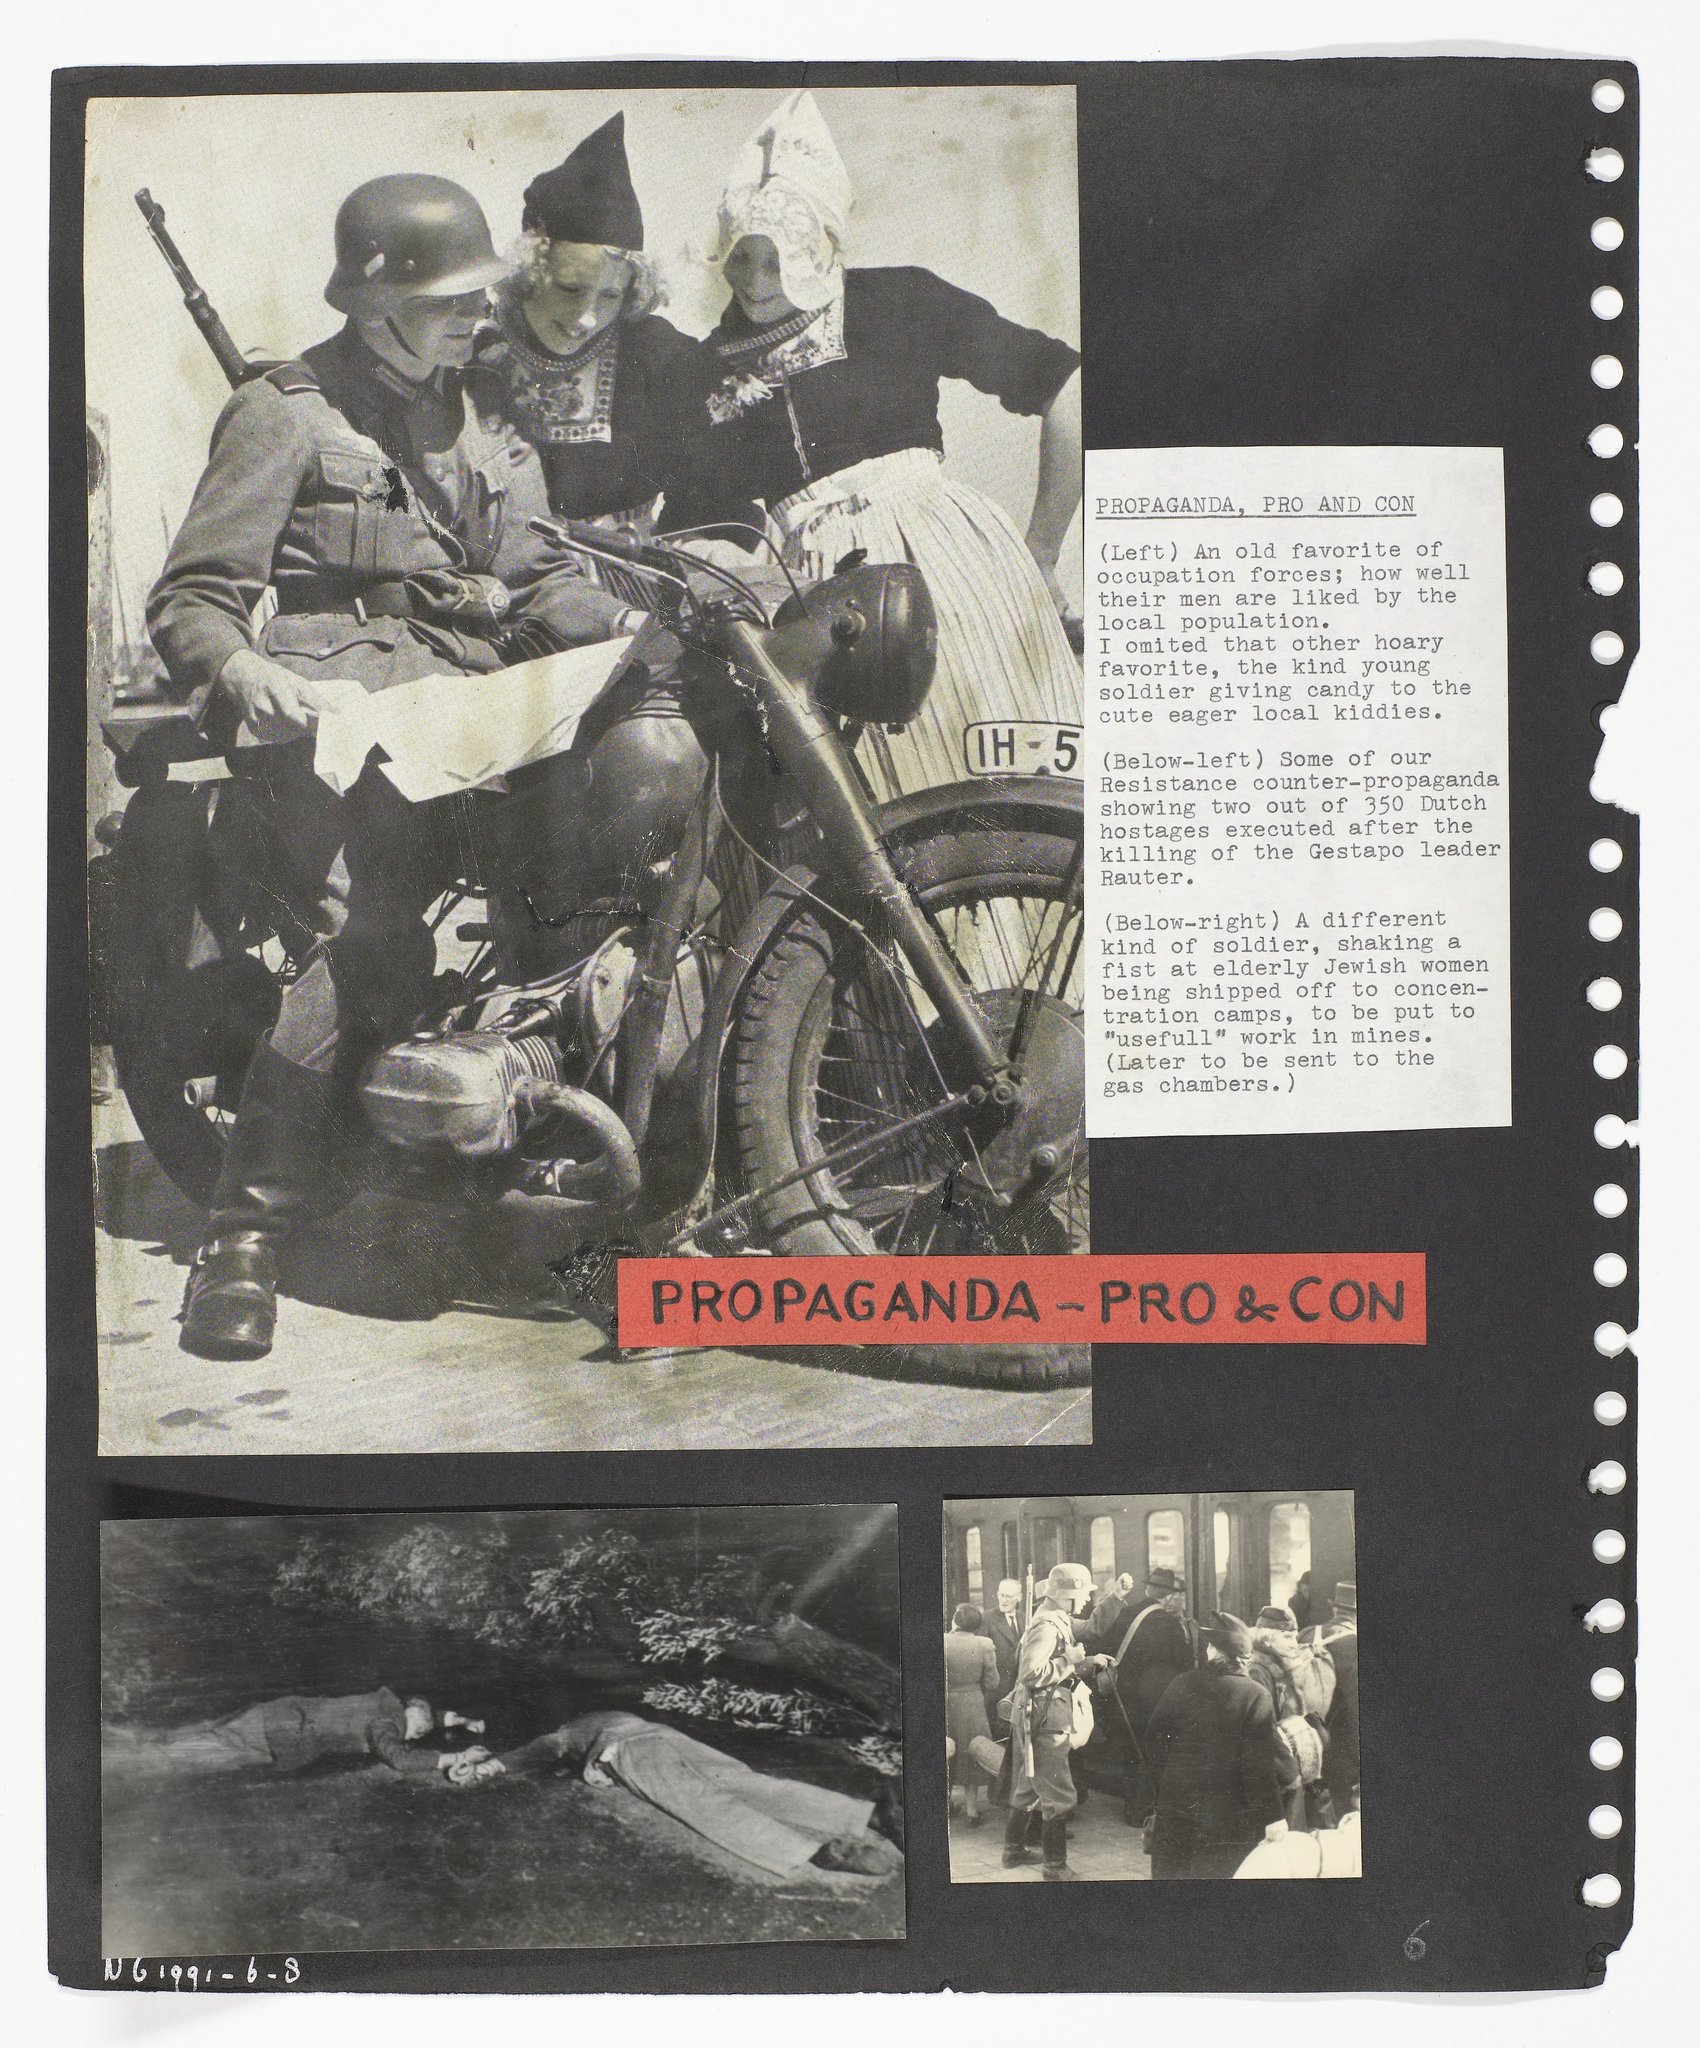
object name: album leaf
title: Drie gezichten van de bezetter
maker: Anonymous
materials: paper, plastic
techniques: photography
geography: netherlands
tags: amsterdam, tonny van renterghem, berlin, fritz kahlenberg, modern forms of military vehicles, underground movement, partisans, occupation ~ war, netherlands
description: Drie foto's die drie aspecten vertonen van de Duitse bezetter: foto l.b. een Duitse soldaat in gesprek met twee Volendammer meisjes. Foto l.o. twee geëxcecuteerde gijzelaars. Foto r.o. Duitse soldaat beveelt Joodse Nederlanders de trein in te stappen.